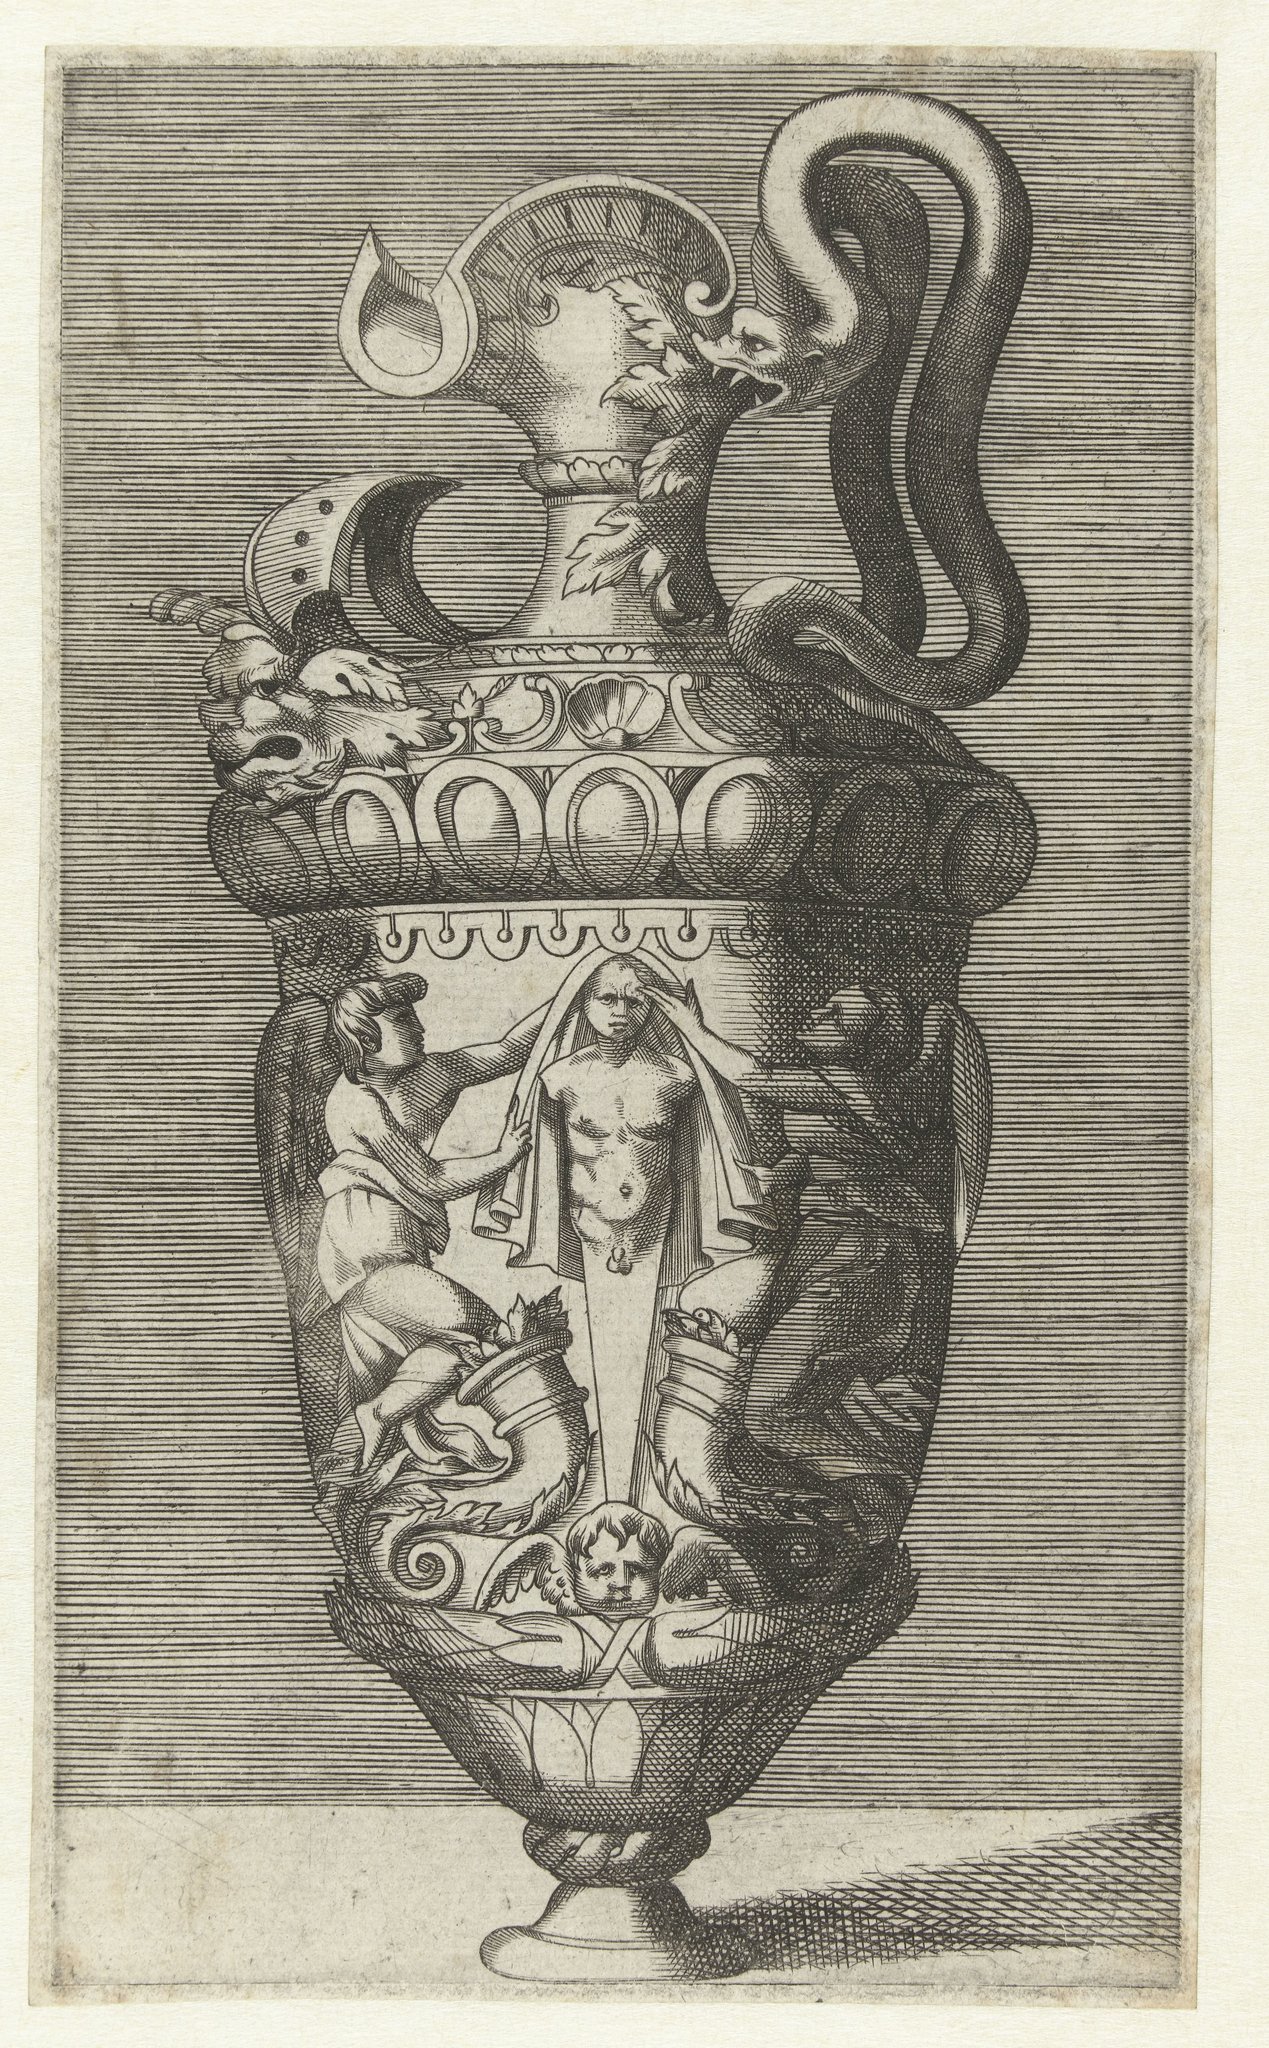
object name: ornament print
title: Kan met een dubbel oor, bestaande uit twee slangen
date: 1551-1580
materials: paper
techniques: engraving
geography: france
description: De buik van de kan is gedecoreerd met twee engelen ter weerszijden van een herme met een doek over het hoofd. Horizontaal gearceerde achtergrond. Blad uit serie van 12 bladen.